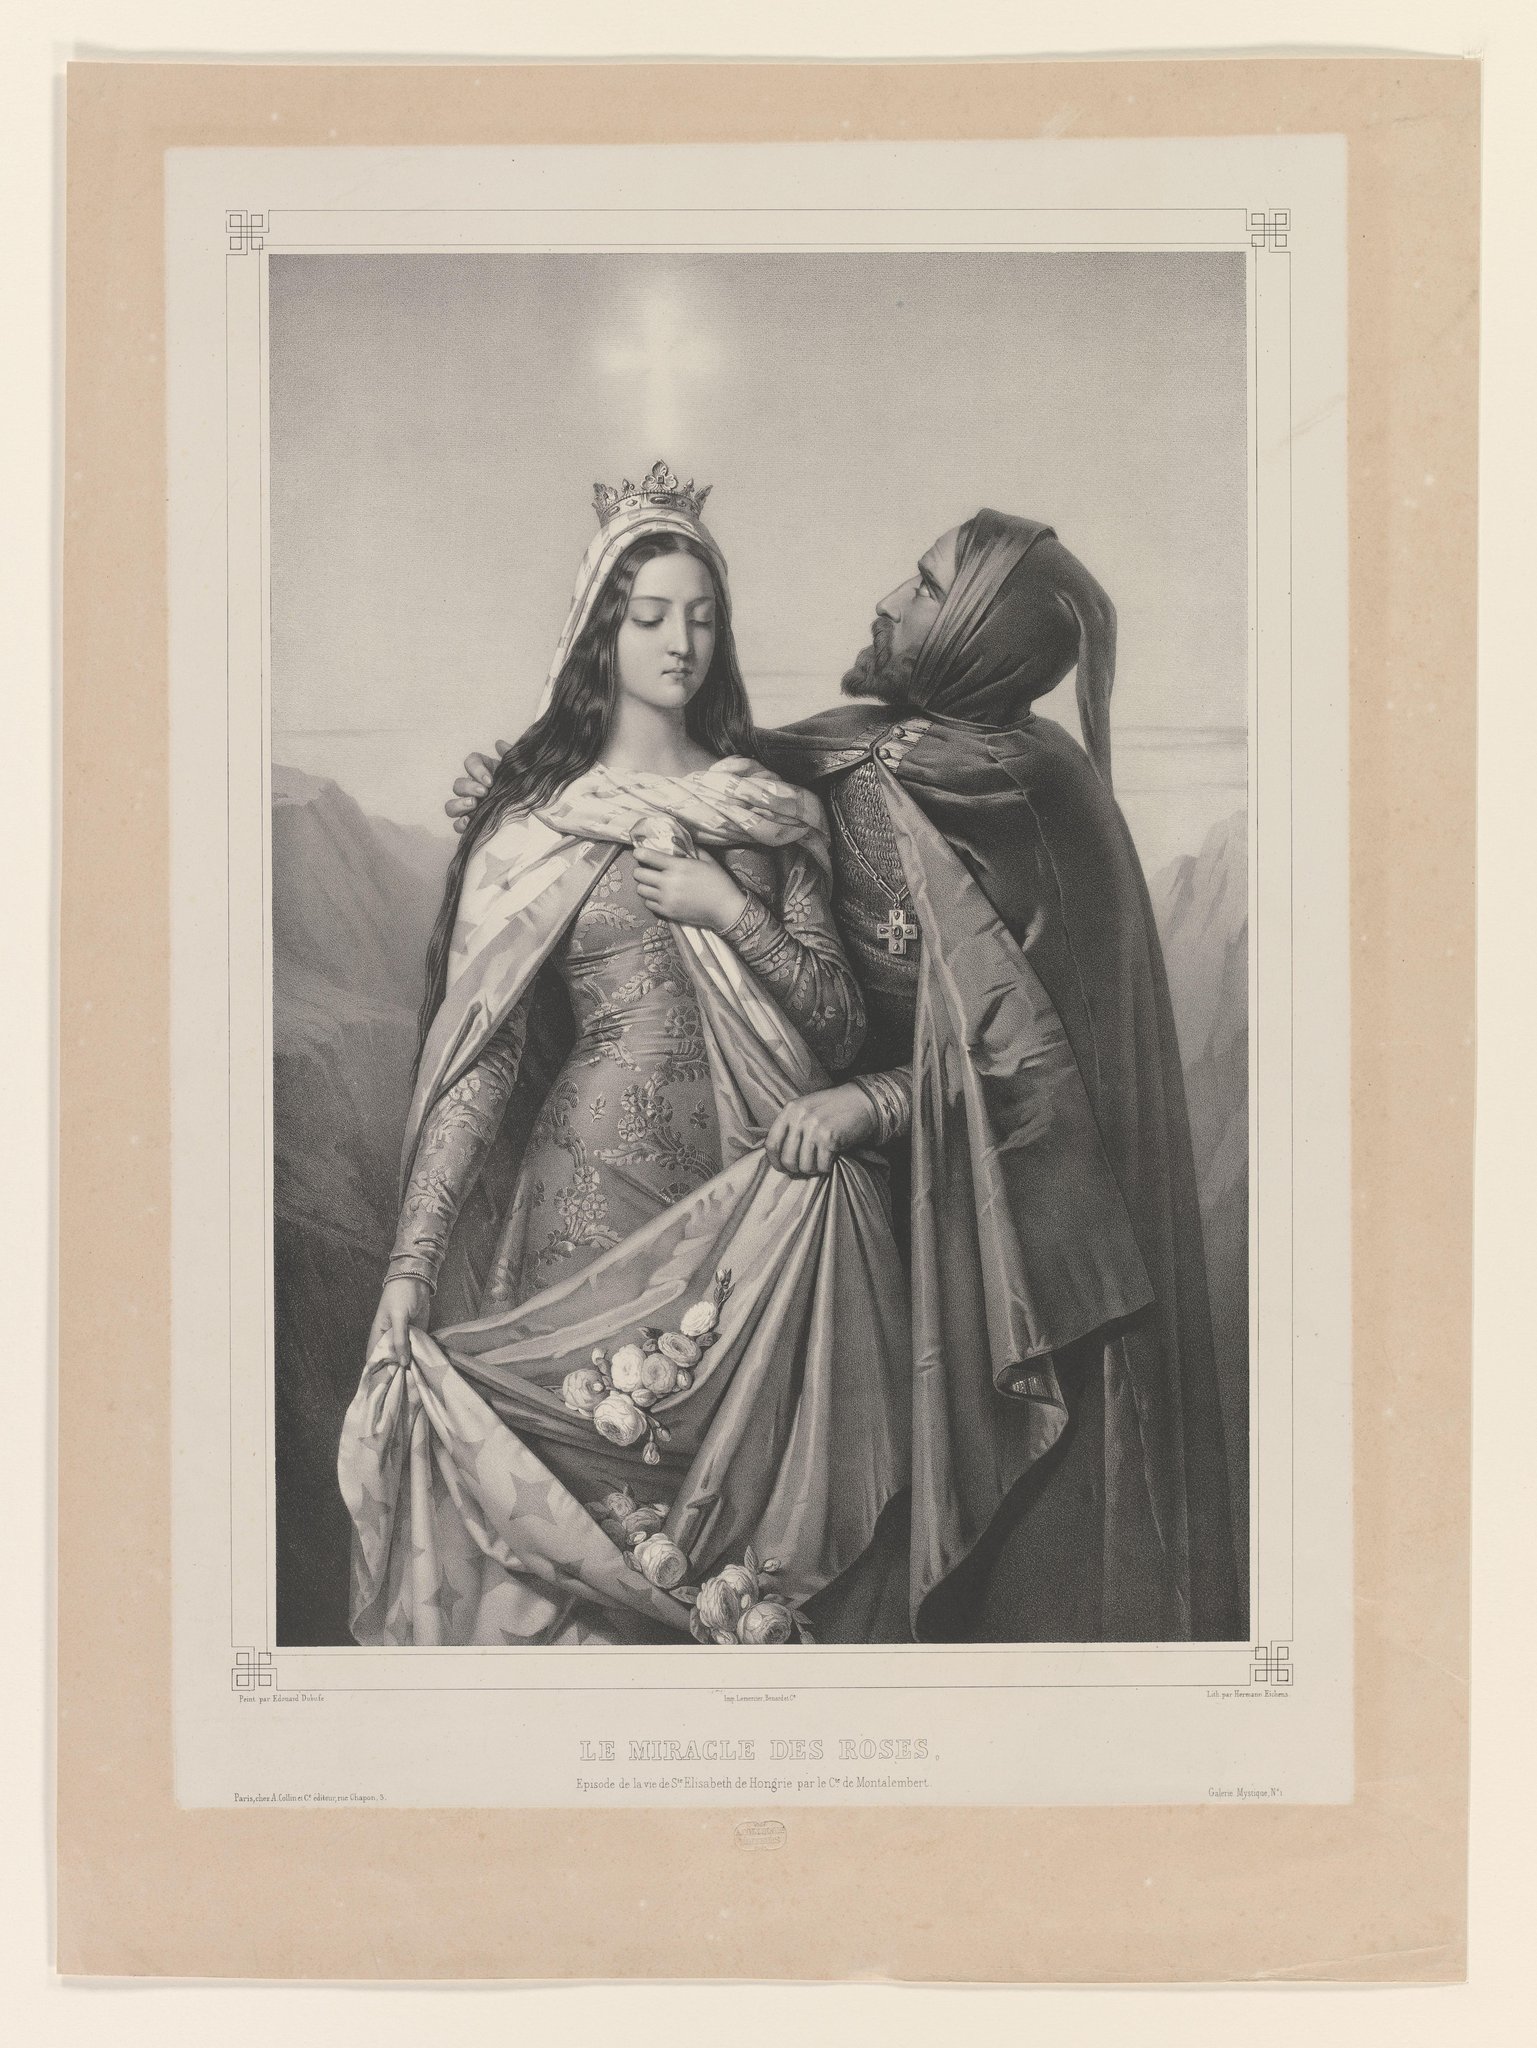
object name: print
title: Heilige Elizabeth en het mirakel van de rozen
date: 1823-1886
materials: paper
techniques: lithograph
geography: paris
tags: the wife and widow of the landgrave of thuringia, and franciscan tertiary, elisabeth of hungary; possible attributes: beggar, cripple, fish, loaves, leper, model of church, pitcher, roses in lap, scald-head, three crowns, king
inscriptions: check stamp: Lugt 4003, collector's mark: Lugt 2228